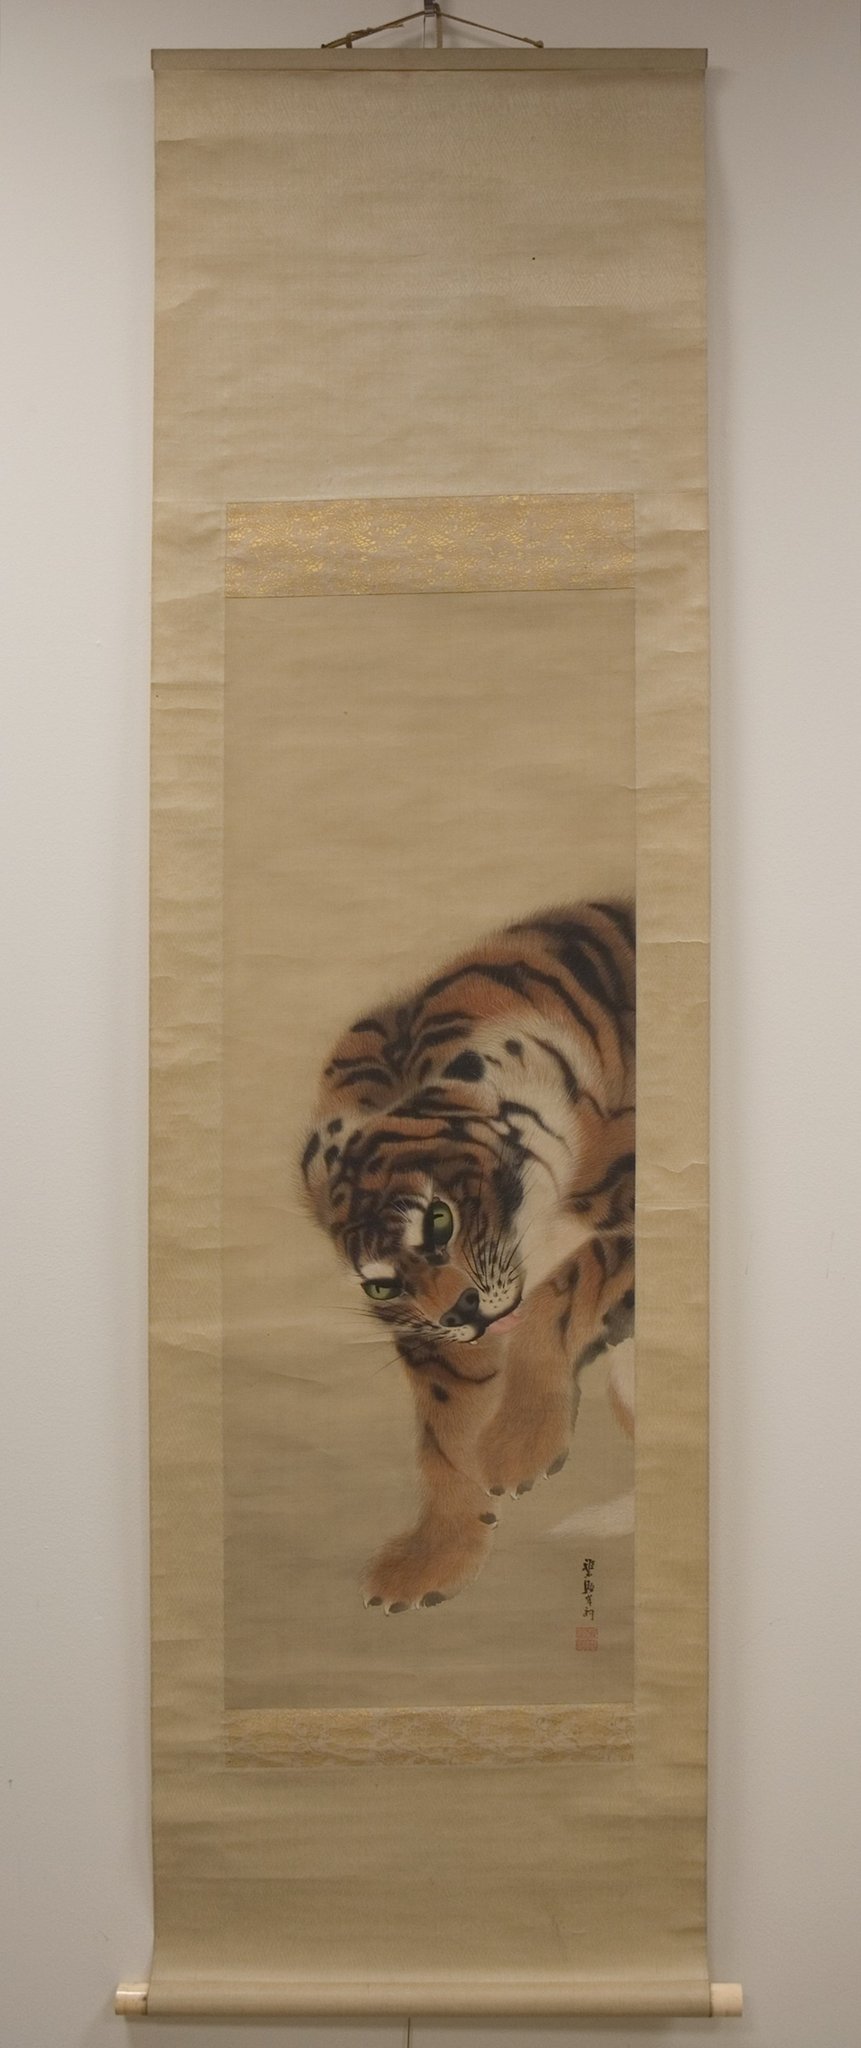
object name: hanging scroll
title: Tiger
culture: japanese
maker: gan ku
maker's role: artist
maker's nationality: japanese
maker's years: 1749-1838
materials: ink, silk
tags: tigers